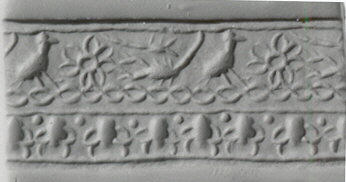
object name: cylinder seal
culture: western asian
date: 2000-1001 BCE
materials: bronze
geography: western asia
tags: birds,flowers